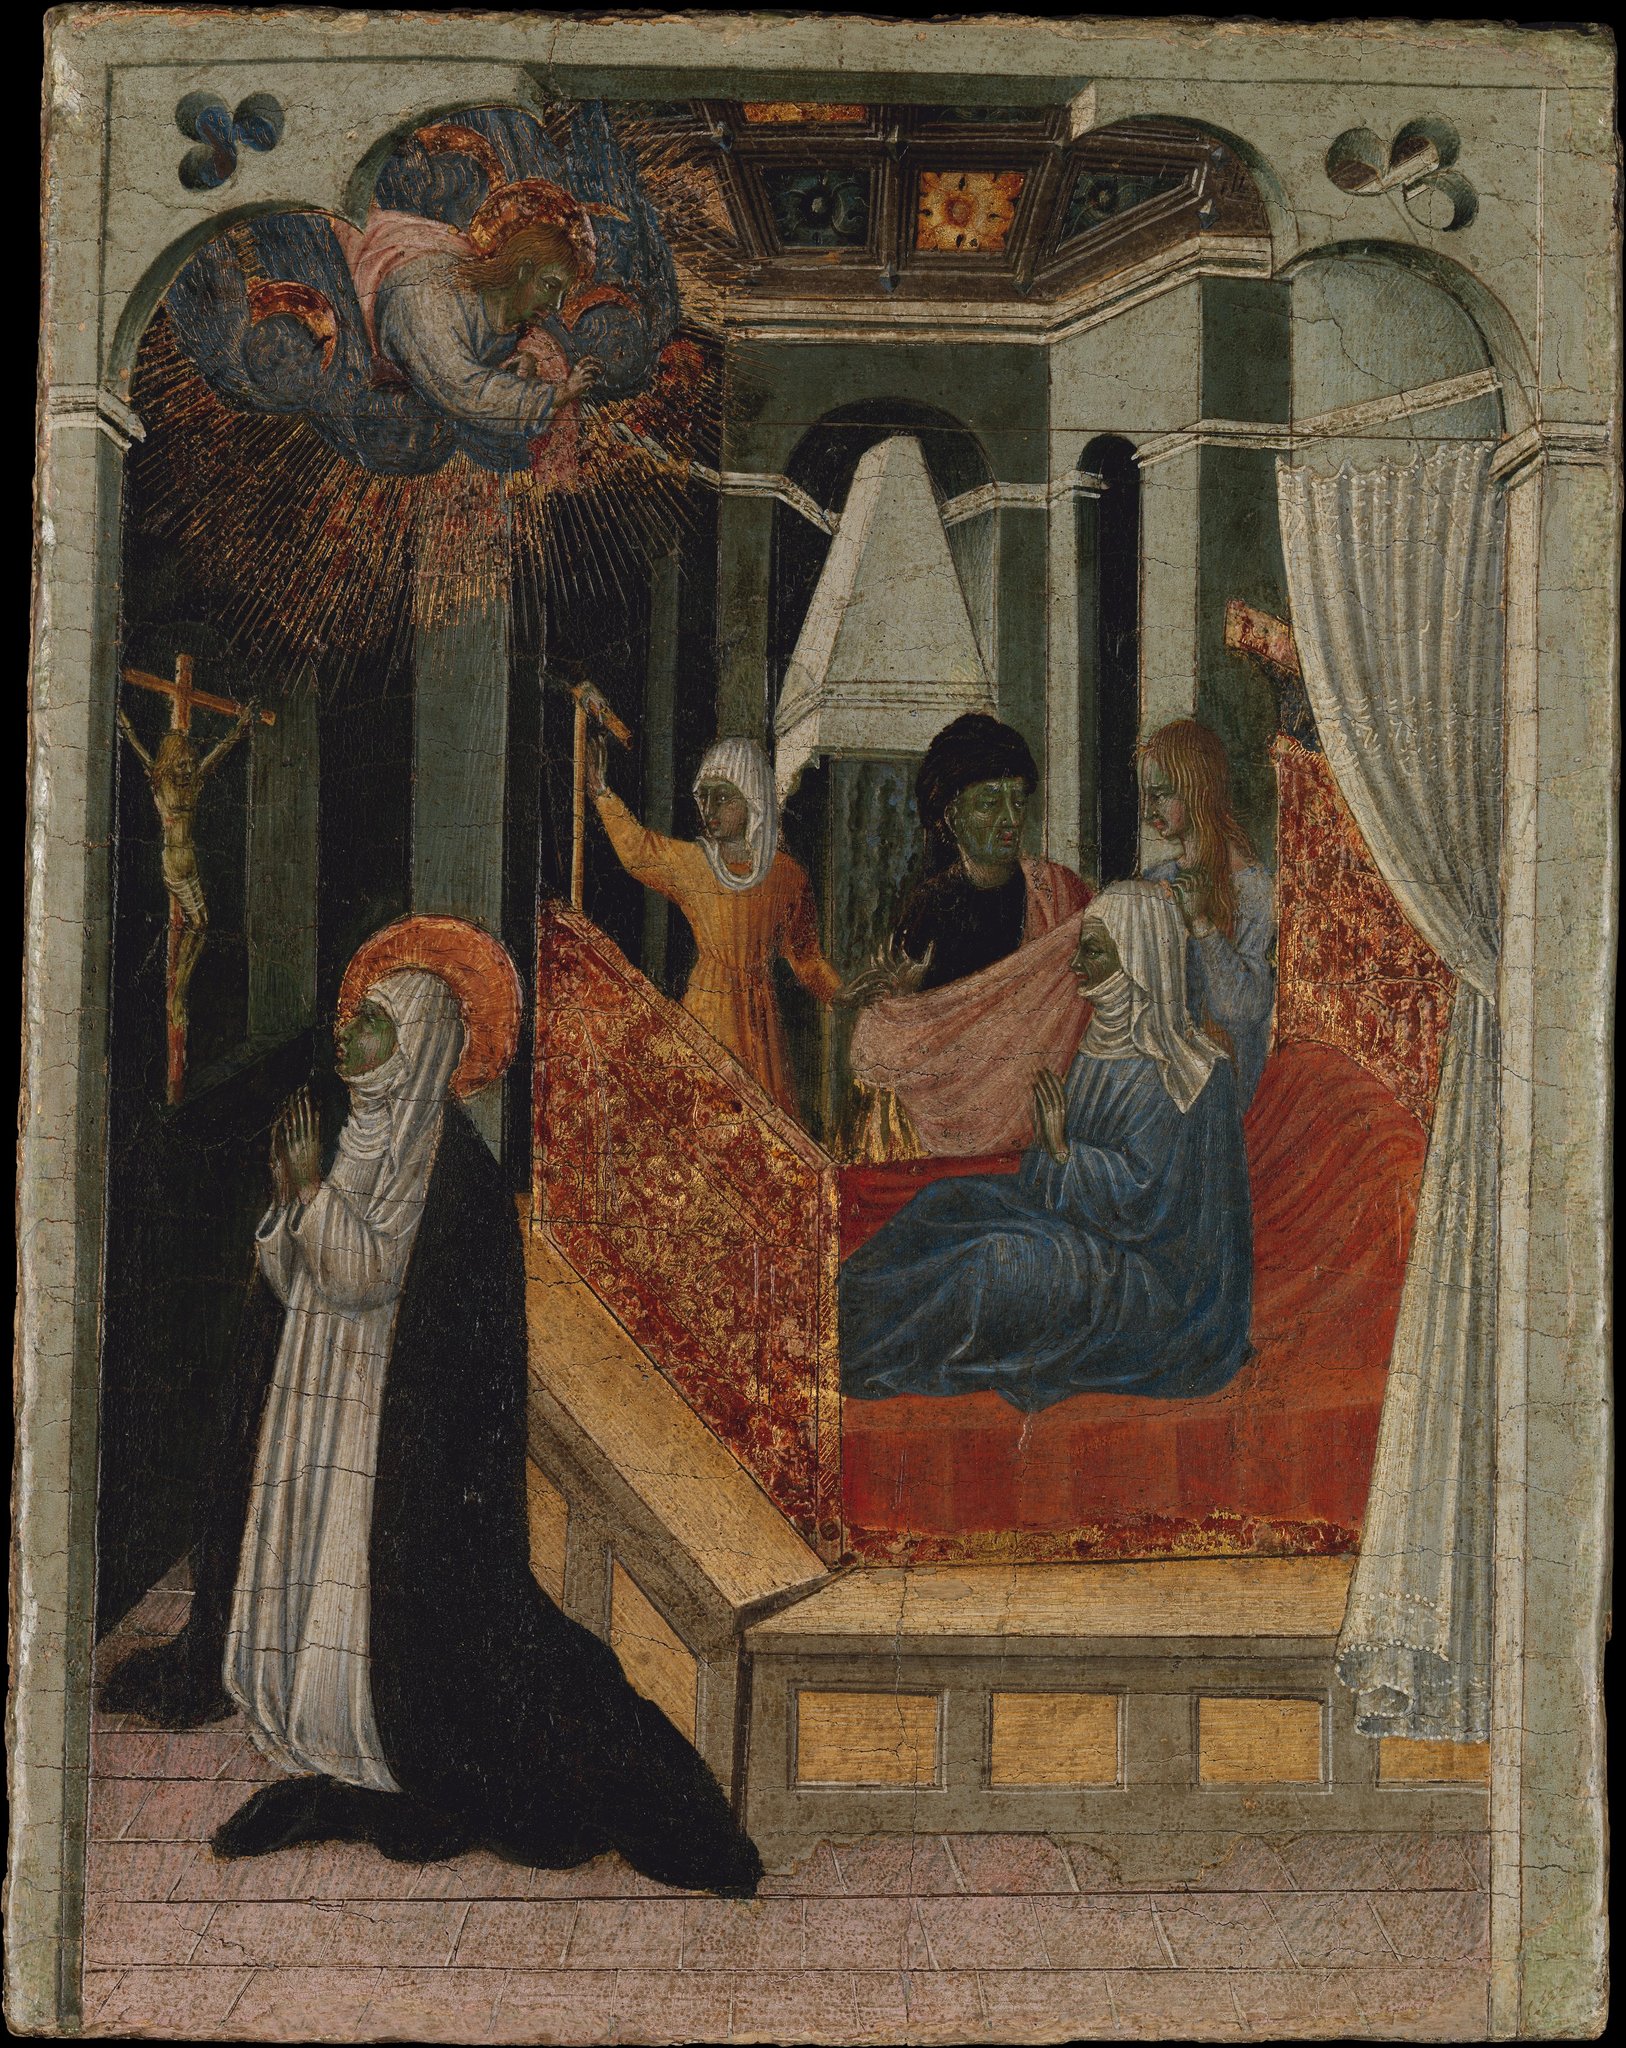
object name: painting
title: Saint Catherine of Siena Beseeching Christ to Resuscitate Her Mother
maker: giovanni di paolo (giovanni di paolo di grazia)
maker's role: artist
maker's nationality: italian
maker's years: 1398-1482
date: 1447-1465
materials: gold, paint, wood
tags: men,women,saint catherine,crucifixion,beds